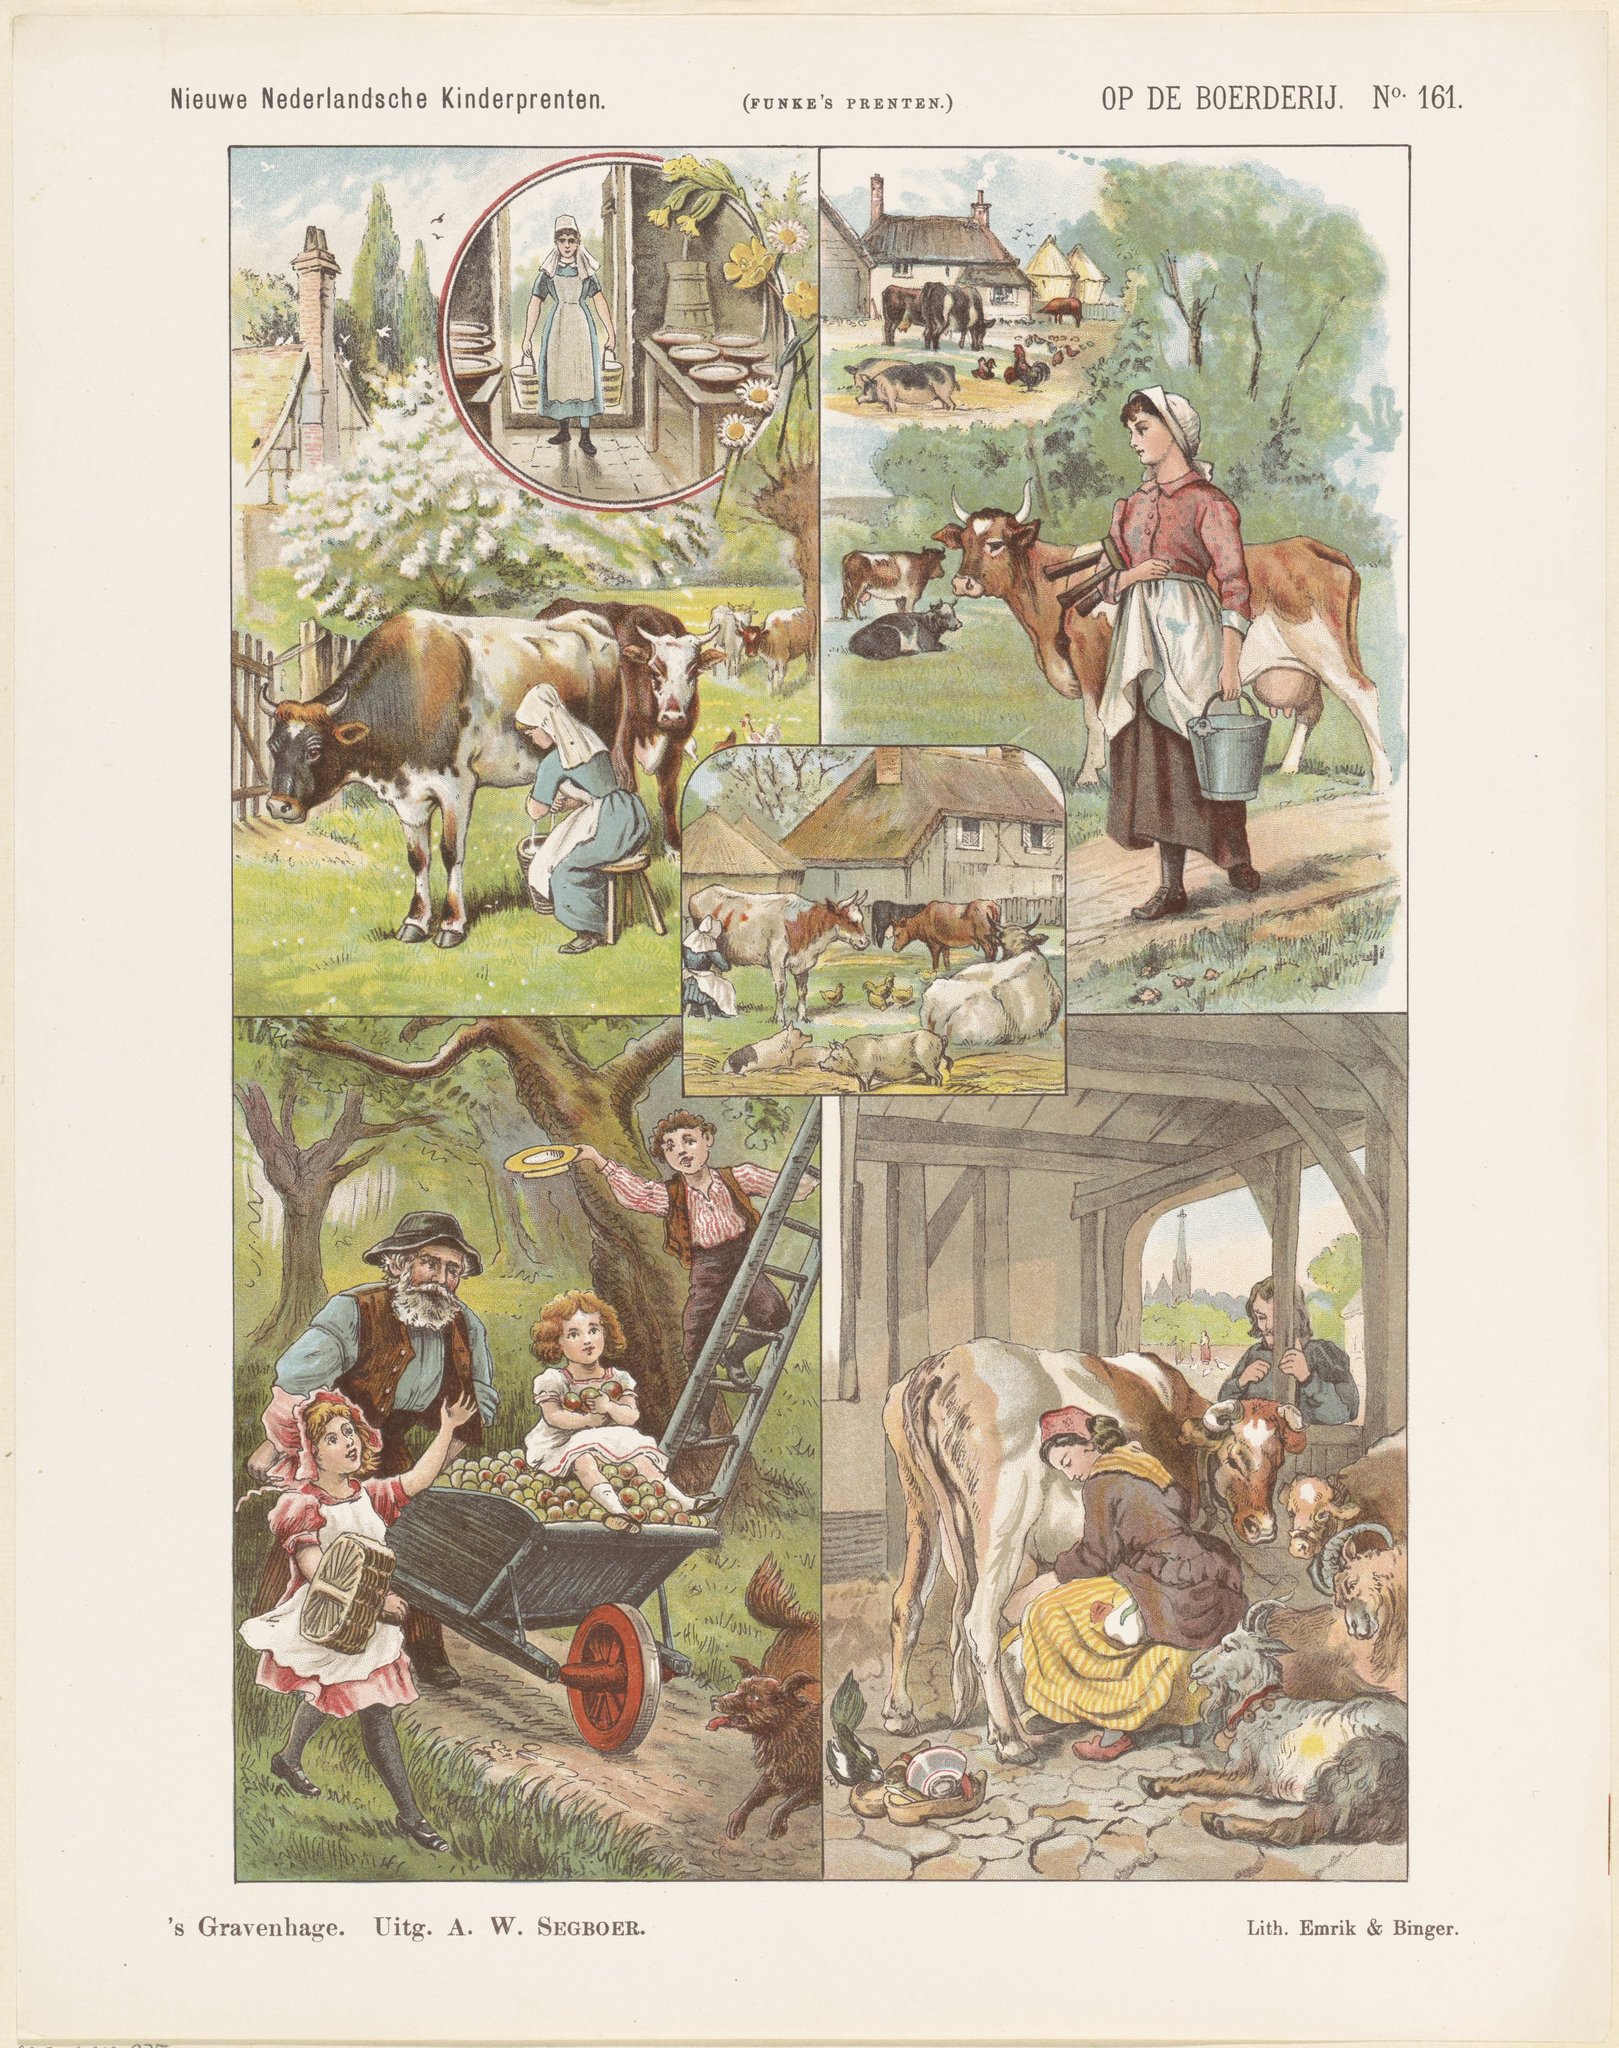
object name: print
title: Nieuwe Nederlandsche kinderprenten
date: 1903-1919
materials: paper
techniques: lithograph, letterpress printing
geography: haarlem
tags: cow, picking fruit, stall, stable, milking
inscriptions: collector's mark: Lugt 2760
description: Blad met 6 voorstellingen van boerderijtaferelen, zoals koeien melken en appels plukken. Genummerd rechtsboven: No. 161.